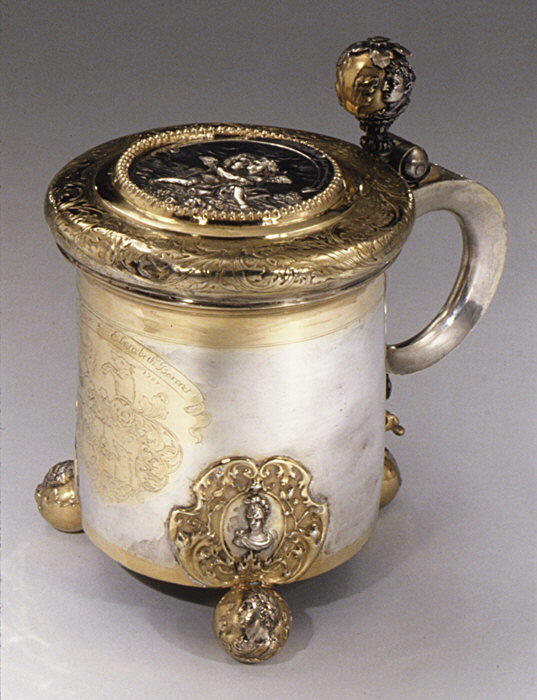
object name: tankard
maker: johann georg eben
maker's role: maker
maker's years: 1610-1710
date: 1707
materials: gilt, silver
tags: faces,men,profiles